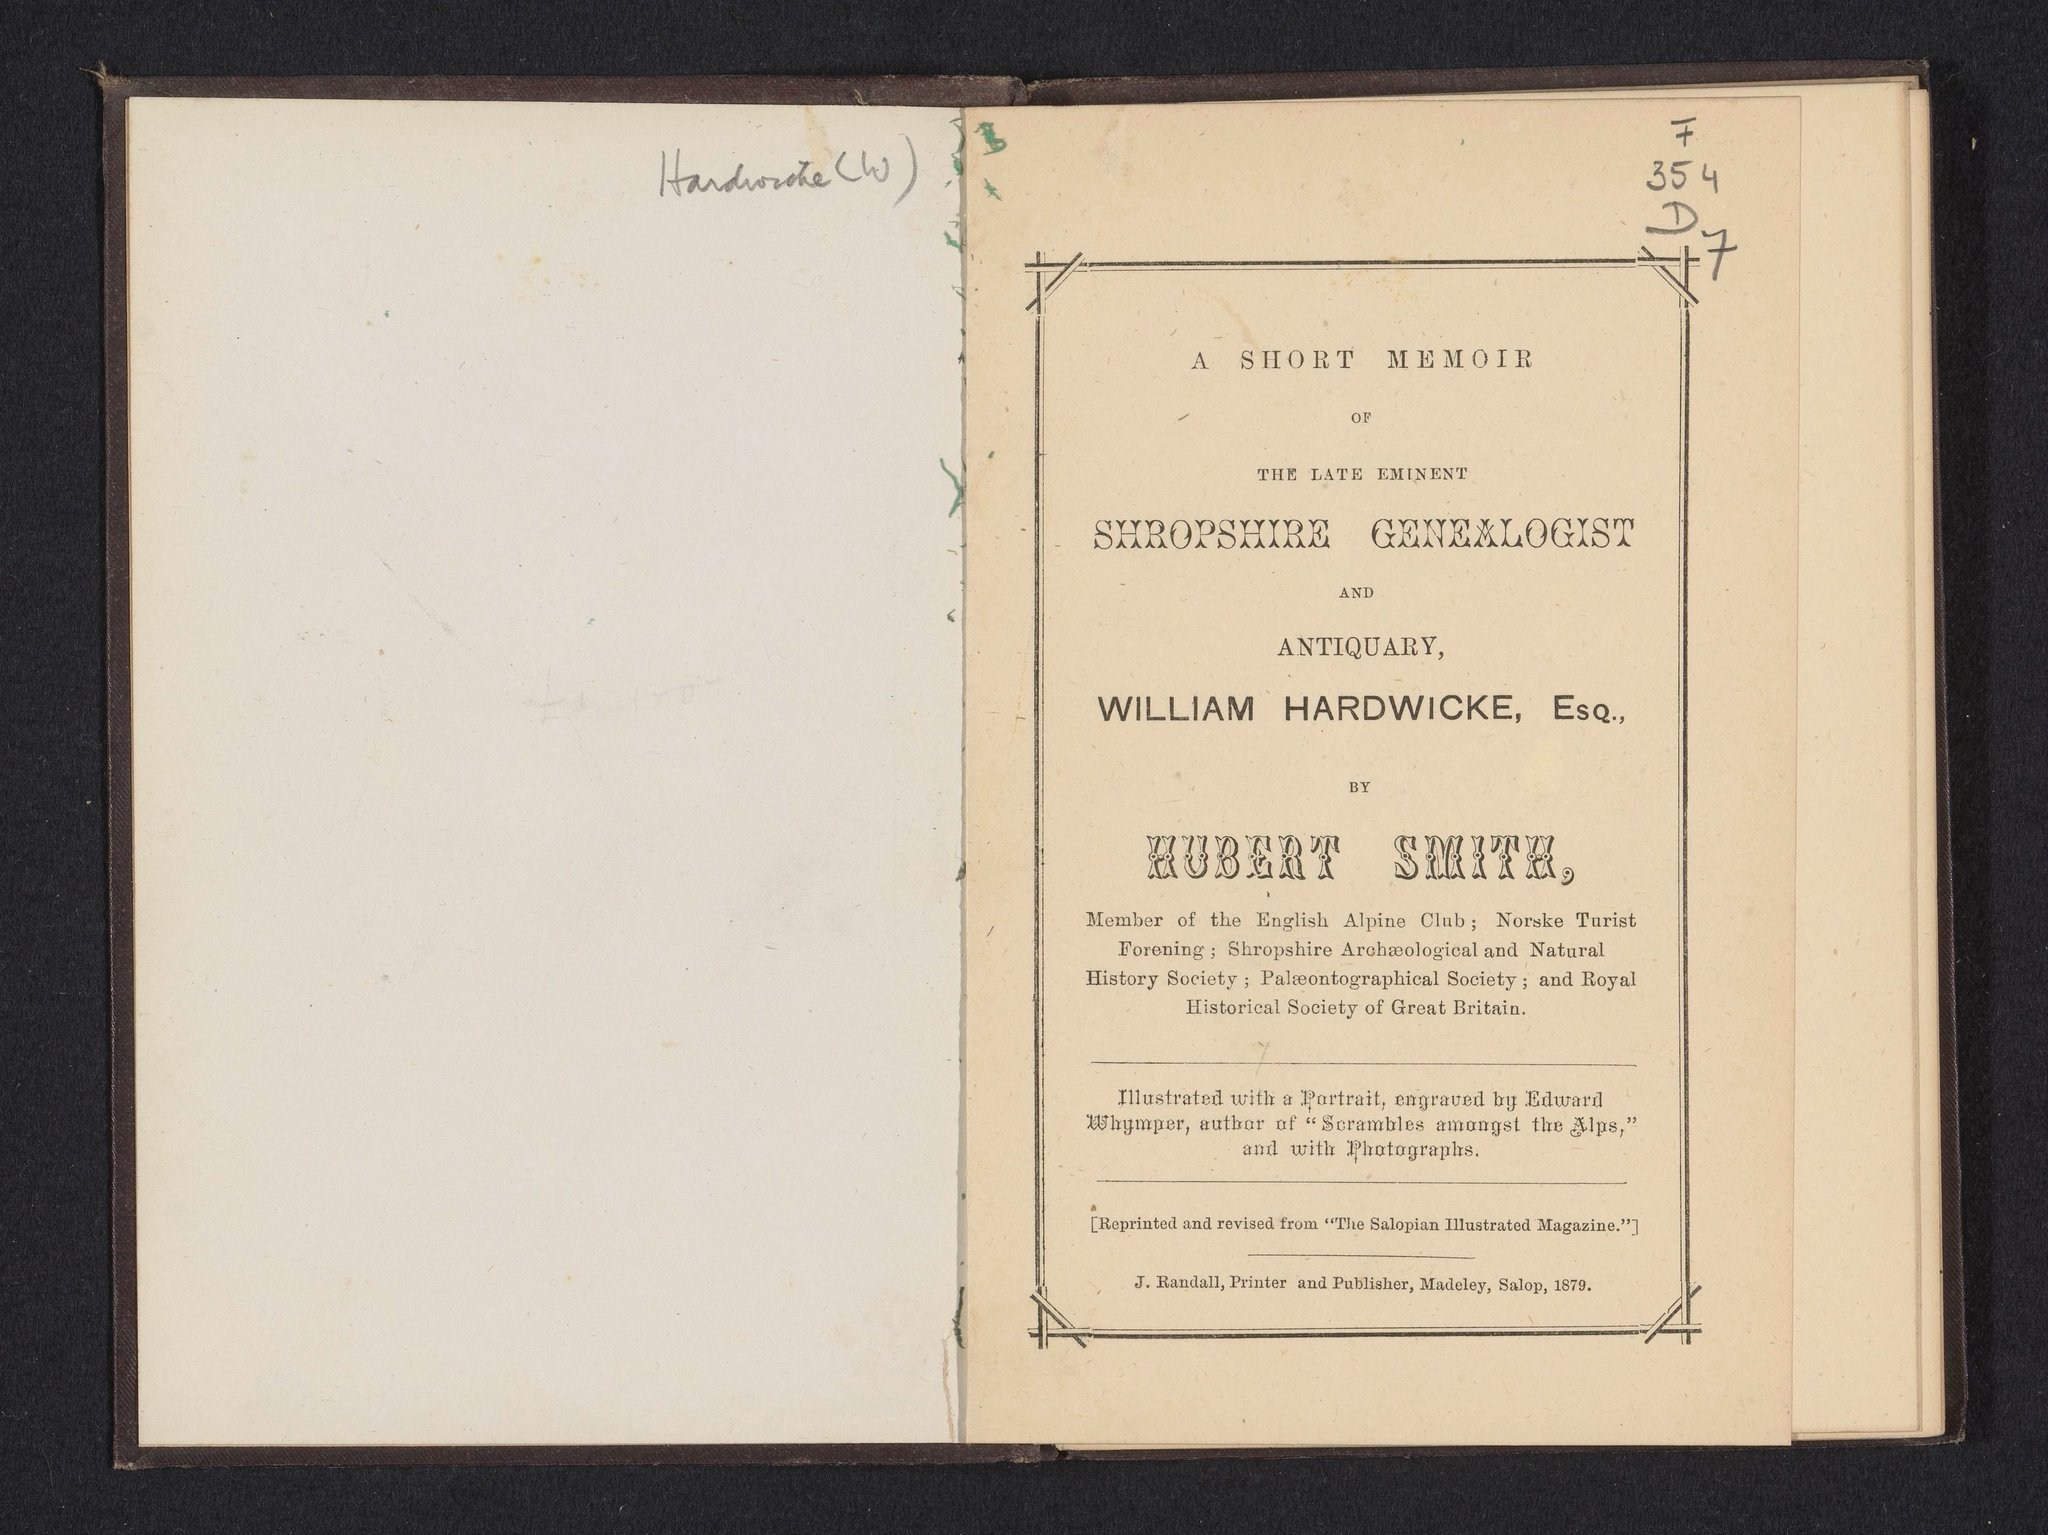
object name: book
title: A short memoir of the late eminent Shropshire genealogist and antiquary William Hardwick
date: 1879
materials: cardboard, linen, paper, photographic support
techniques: albumen print, printing, woodburytype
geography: shropshire